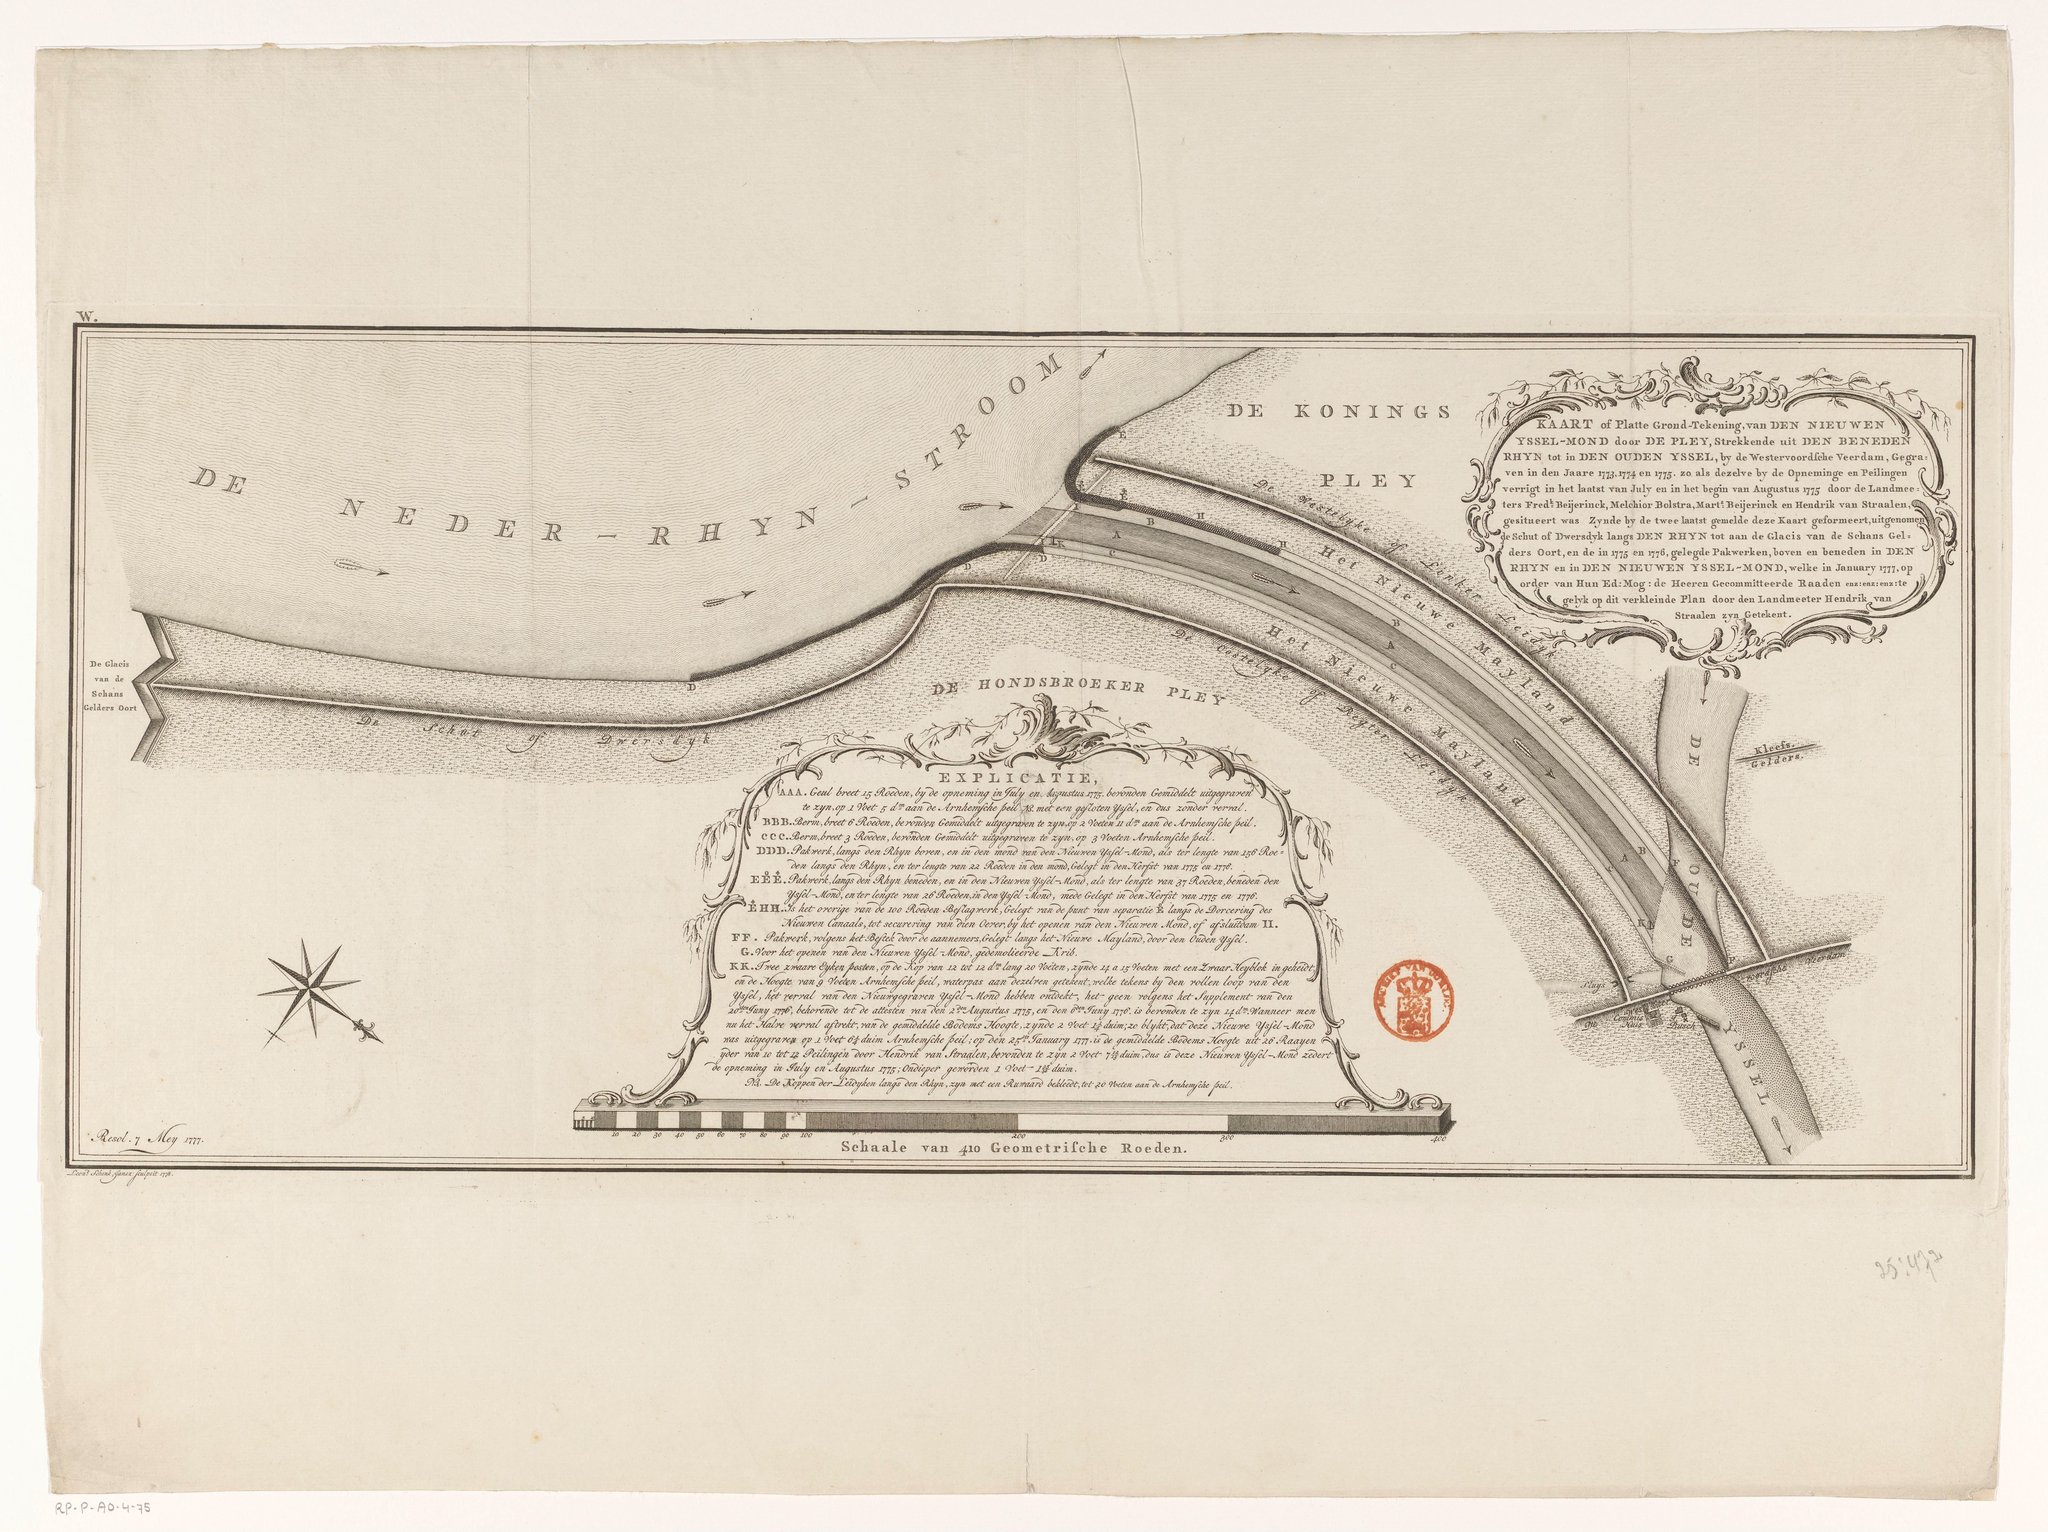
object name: print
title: Kaart van de Neder-Rijn en de IJssel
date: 1778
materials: paper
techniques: engraving, etching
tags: maps of separate countries or regions, river, gelderland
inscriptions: collector's mark: Lugt 19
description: Deze prent komt uit de atlas die hoort bij: Brunings, Christiaan. Verzameling van rapporten, verbaalen en verdere stukken, betreffende de doorsnydingen en werken, welken sedert de conventie in den jaare 1771 (…). 2 delen. Den Haag: ’s Lands Drukkery van Holland, 1798.